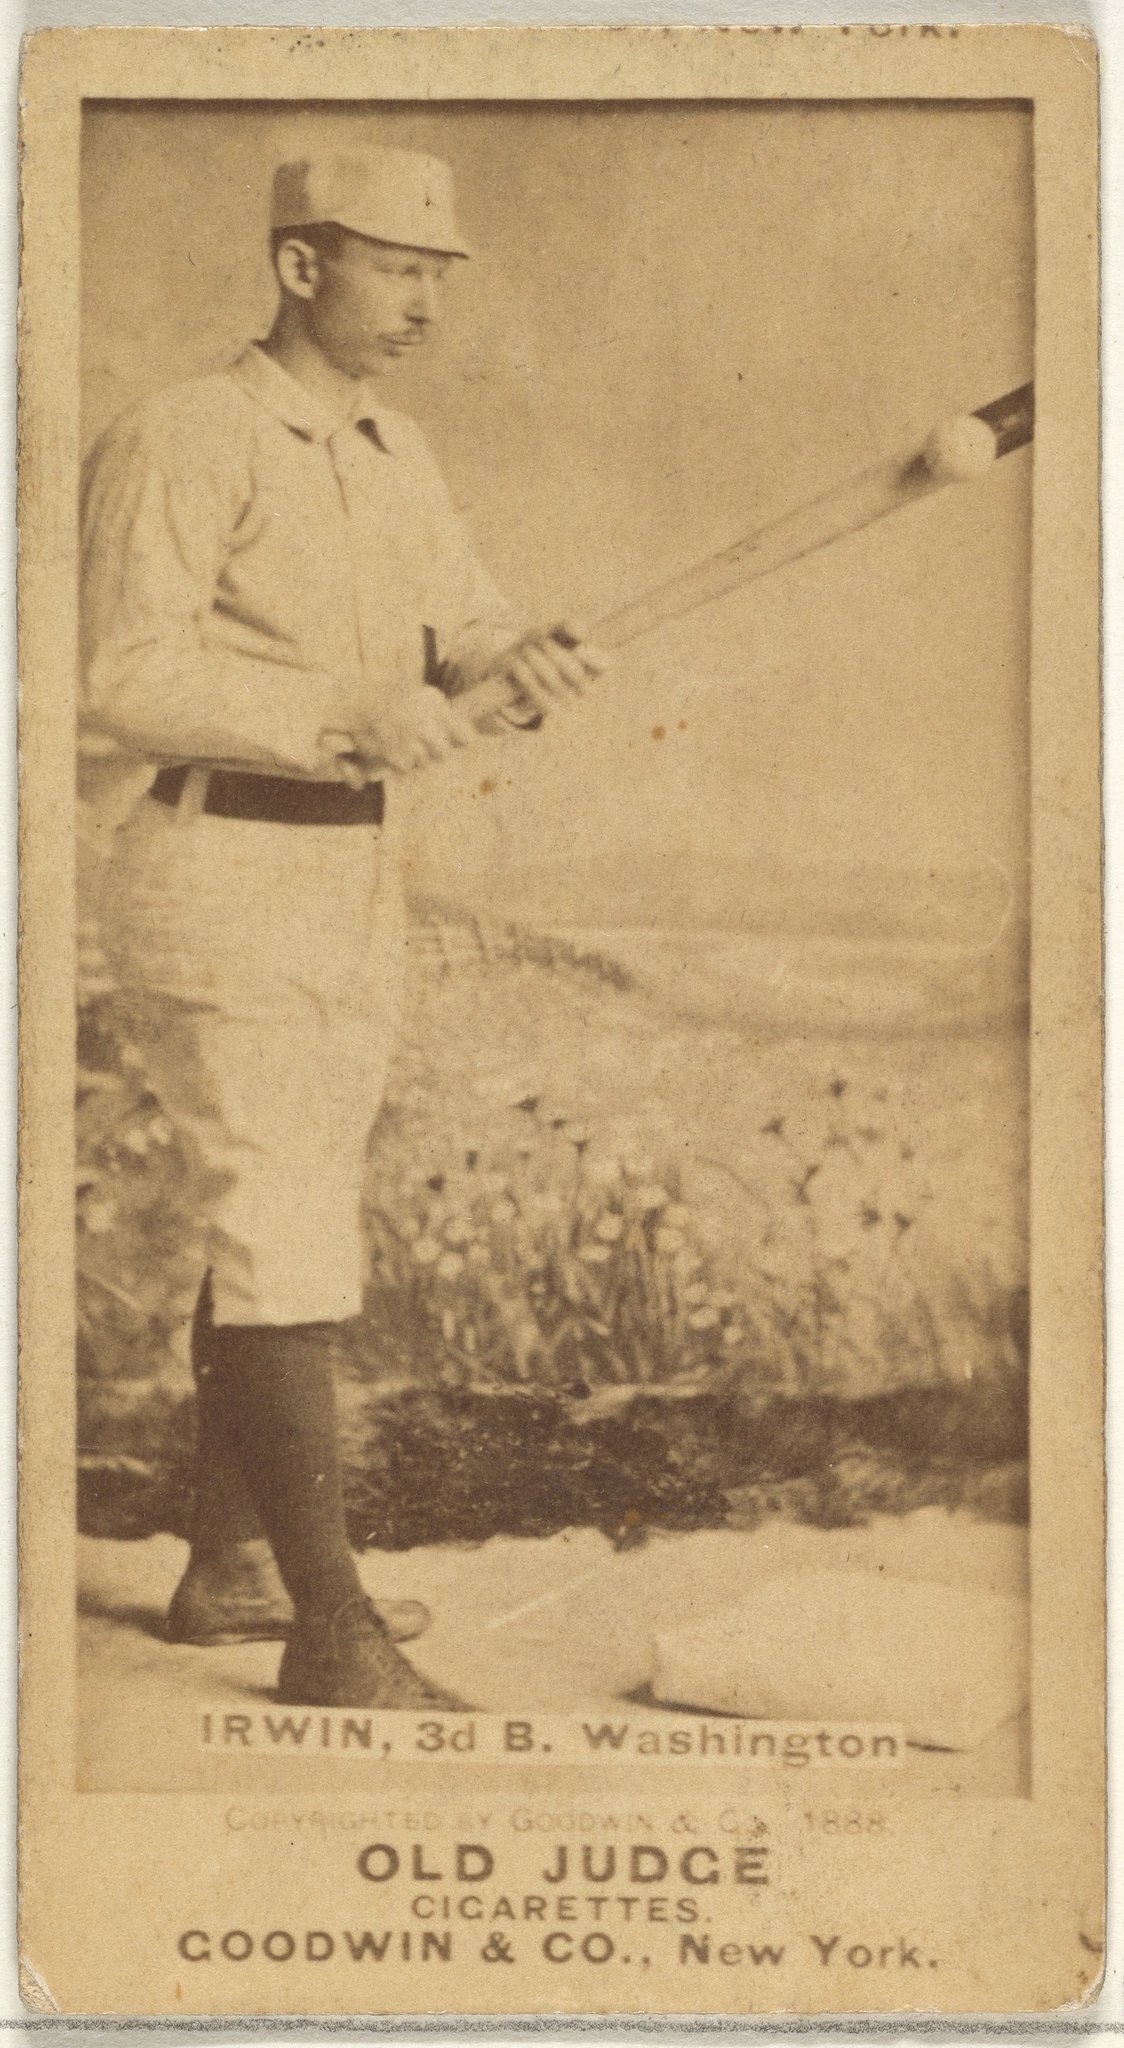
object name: baseball card, photograph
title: John Irwin, 3rd Base, Washington Nationals, from the Old Judge series (N172) for Old Judge Cigarettes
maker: goodwin & company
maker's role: publisher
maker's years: 1850-1950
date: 1888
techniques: albumen silver print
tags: men,portraits,baseball,athletes